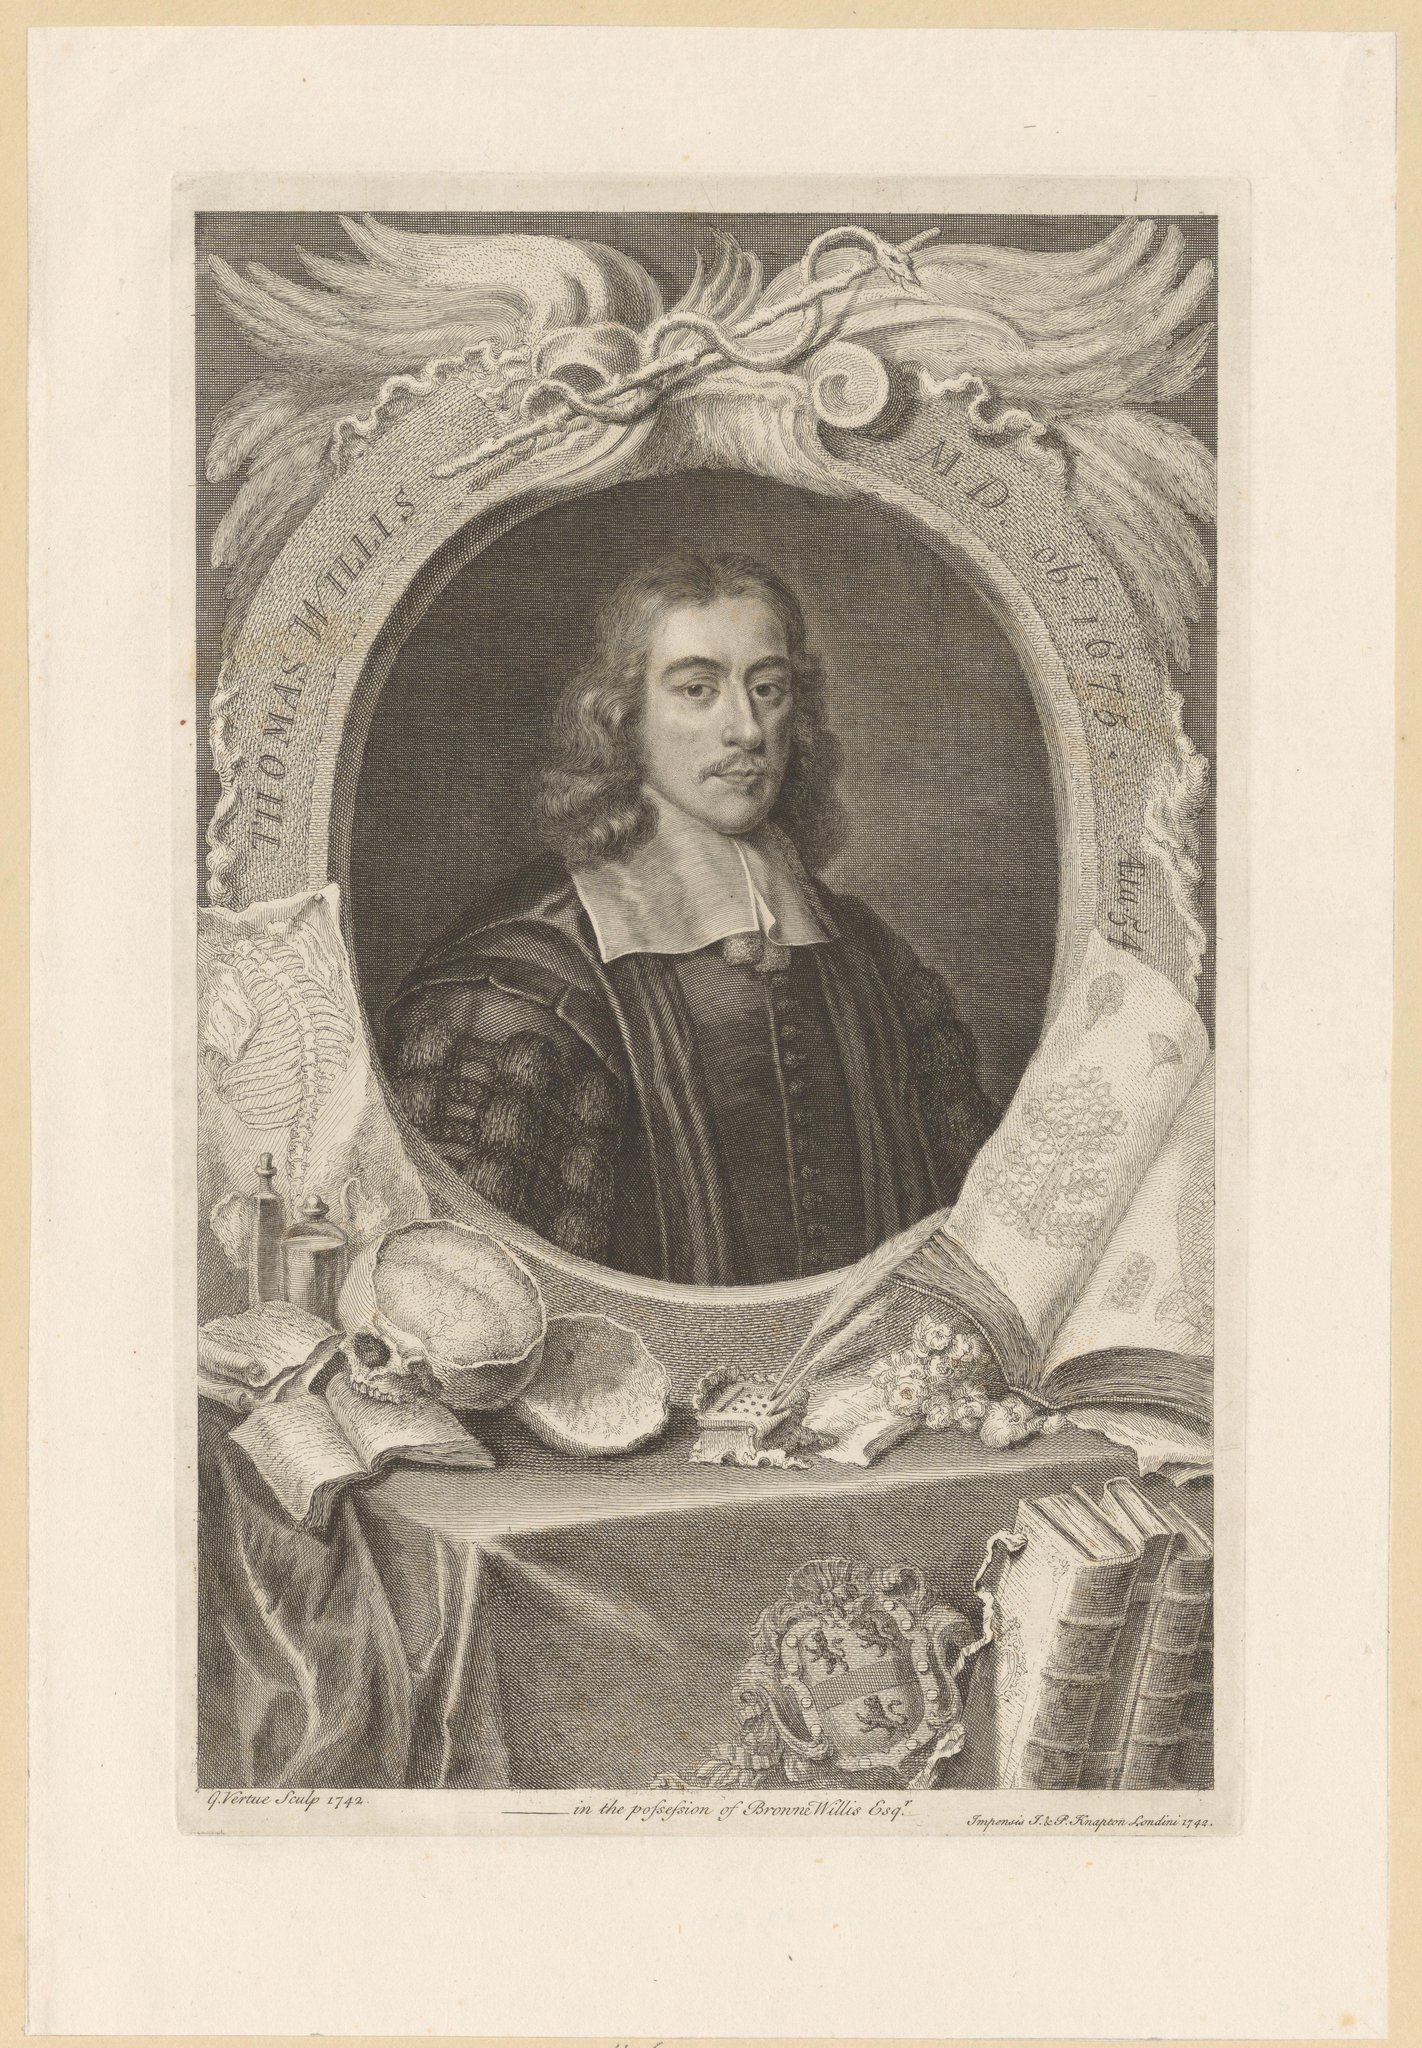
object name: book illustration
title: Portret van Thomas Willis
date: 1742-1747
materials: paper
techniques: engraving, etching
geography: london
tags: london, (human) skull, further education (+ portrait of teacher, professor), historical persons, physician, doctor (+ portrait of scholar, scientist), medical research, branches of medicine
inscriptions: collector's mark: Lugt 240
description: Prent gebruikt in: Birch, Thomas. The heads of illustrious persons of Great Britain (...). Londen: John & Paul Knapton, 1747, p. 118.